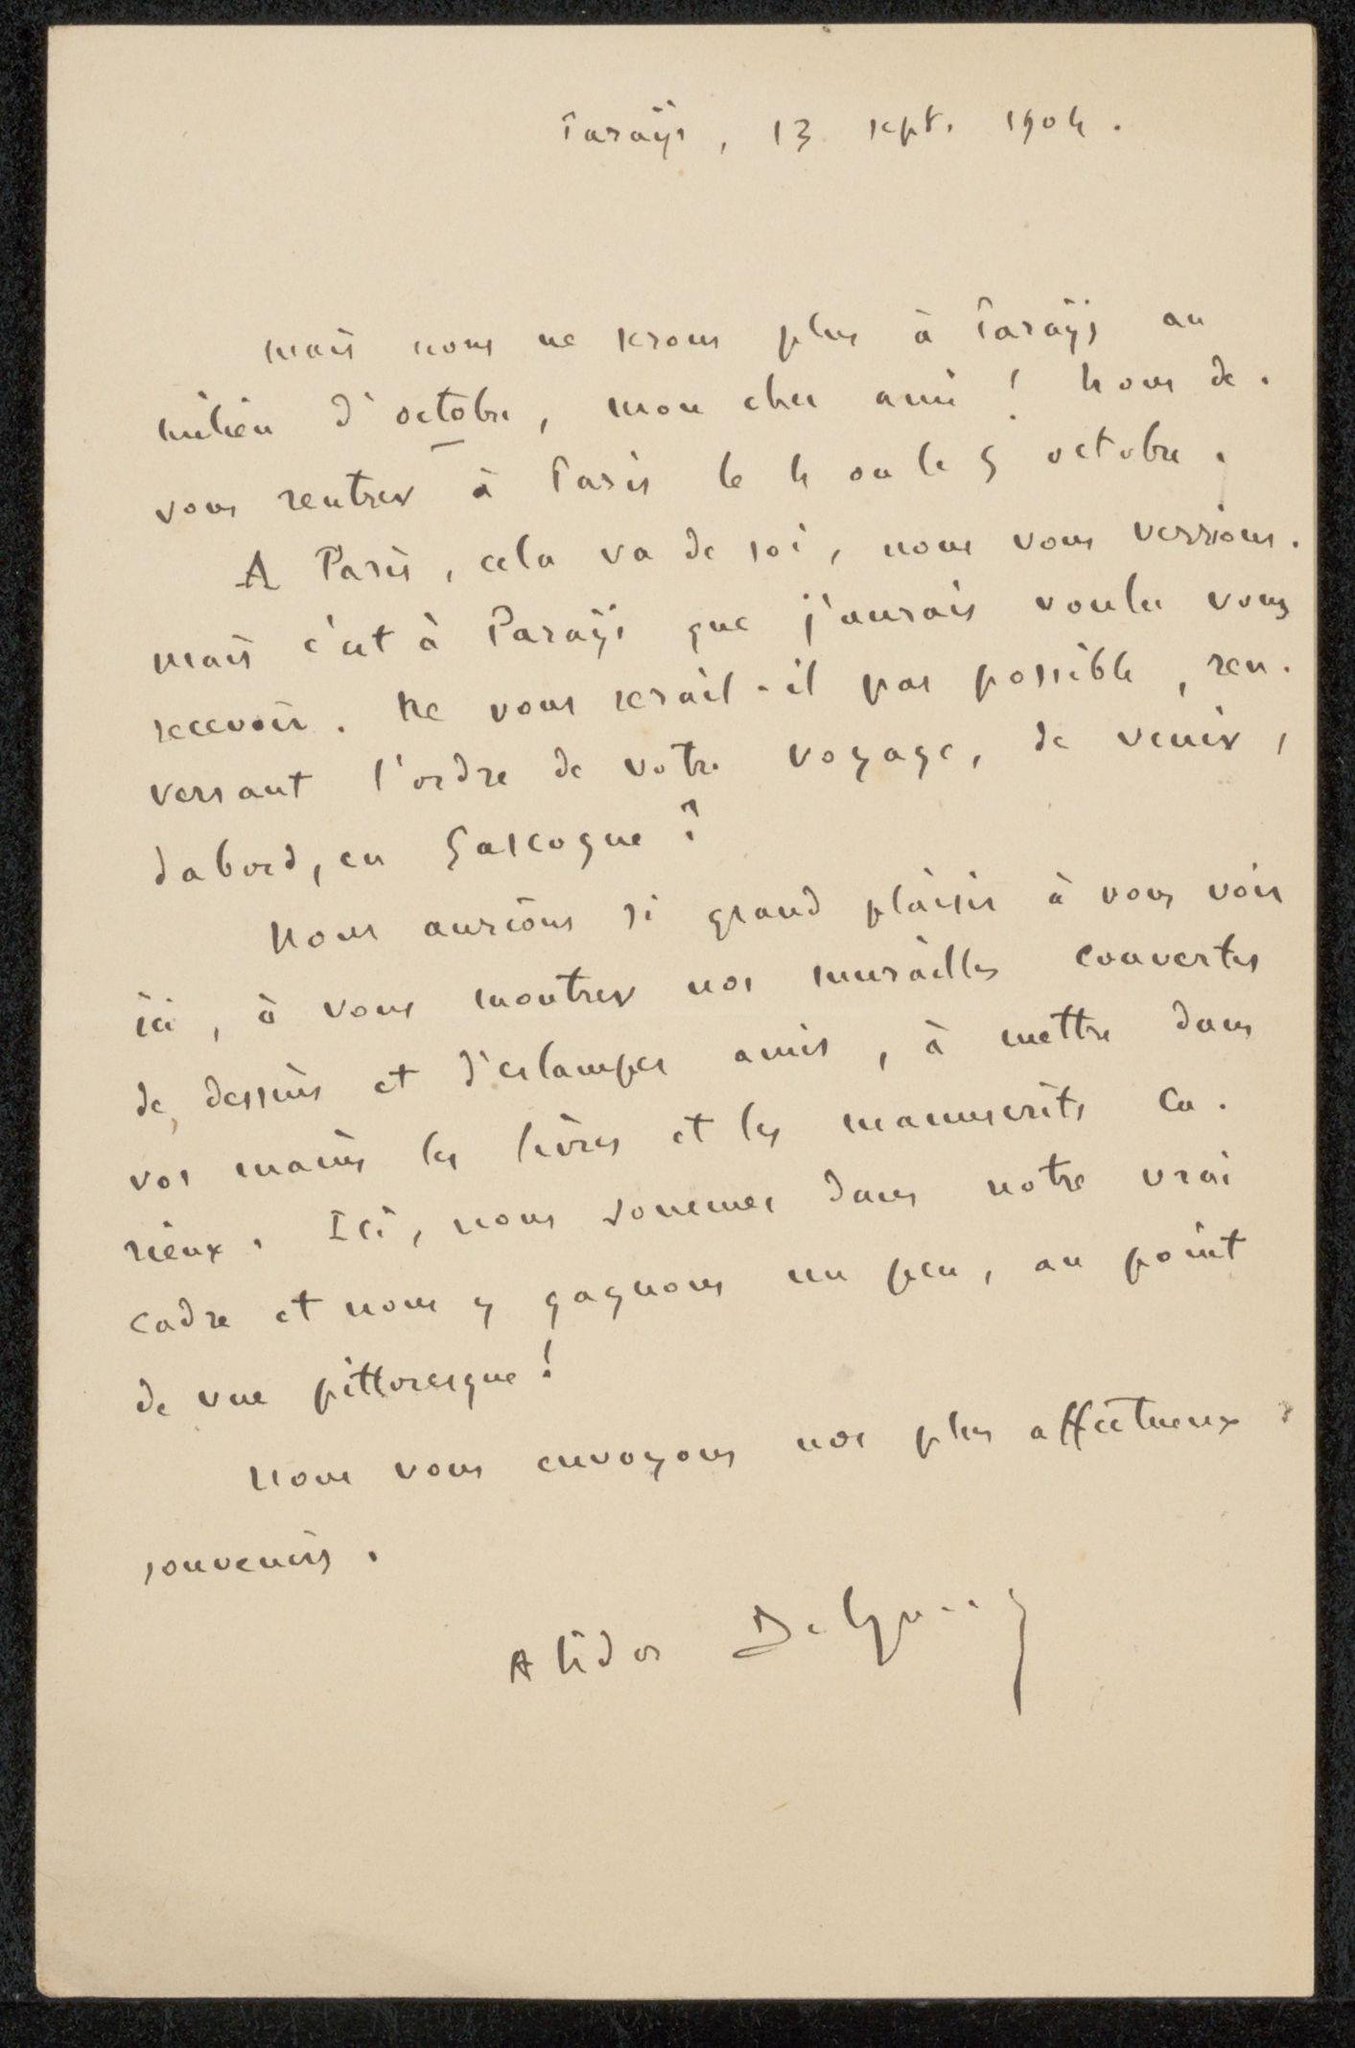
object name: letter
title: Brief aan Philip Zilcken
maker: alidor delzant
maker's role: advocaat, auteur, kunstverzamelaar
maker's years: 1848-1905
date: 1904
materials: ink, paper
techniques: pen, writing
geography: parays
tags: the hague, painter, draughtsman, philip zilcken, painting (including book-illumination, miniature-painting), paris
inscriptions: collector's mark: ‘RPK’